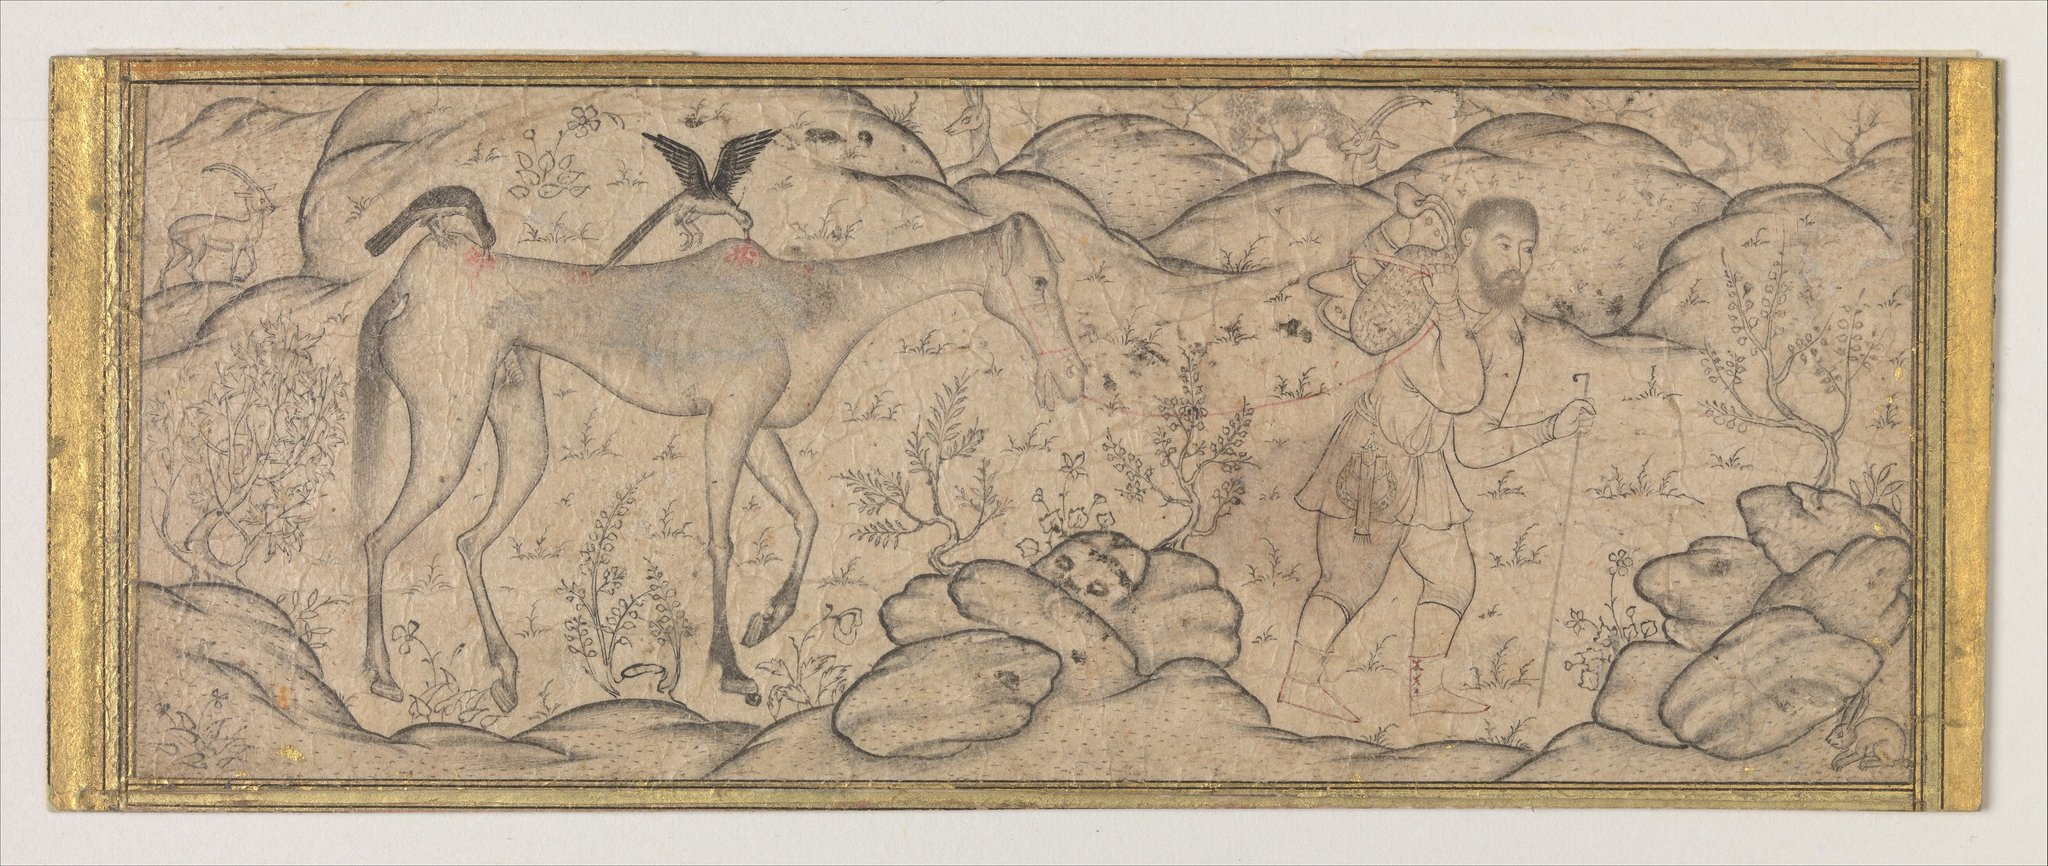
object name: illustrated single work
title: An Emaciated Horse Led by His Master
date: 1567-1600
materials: ink, paper, watercolor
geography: iran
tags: birds,men,horses